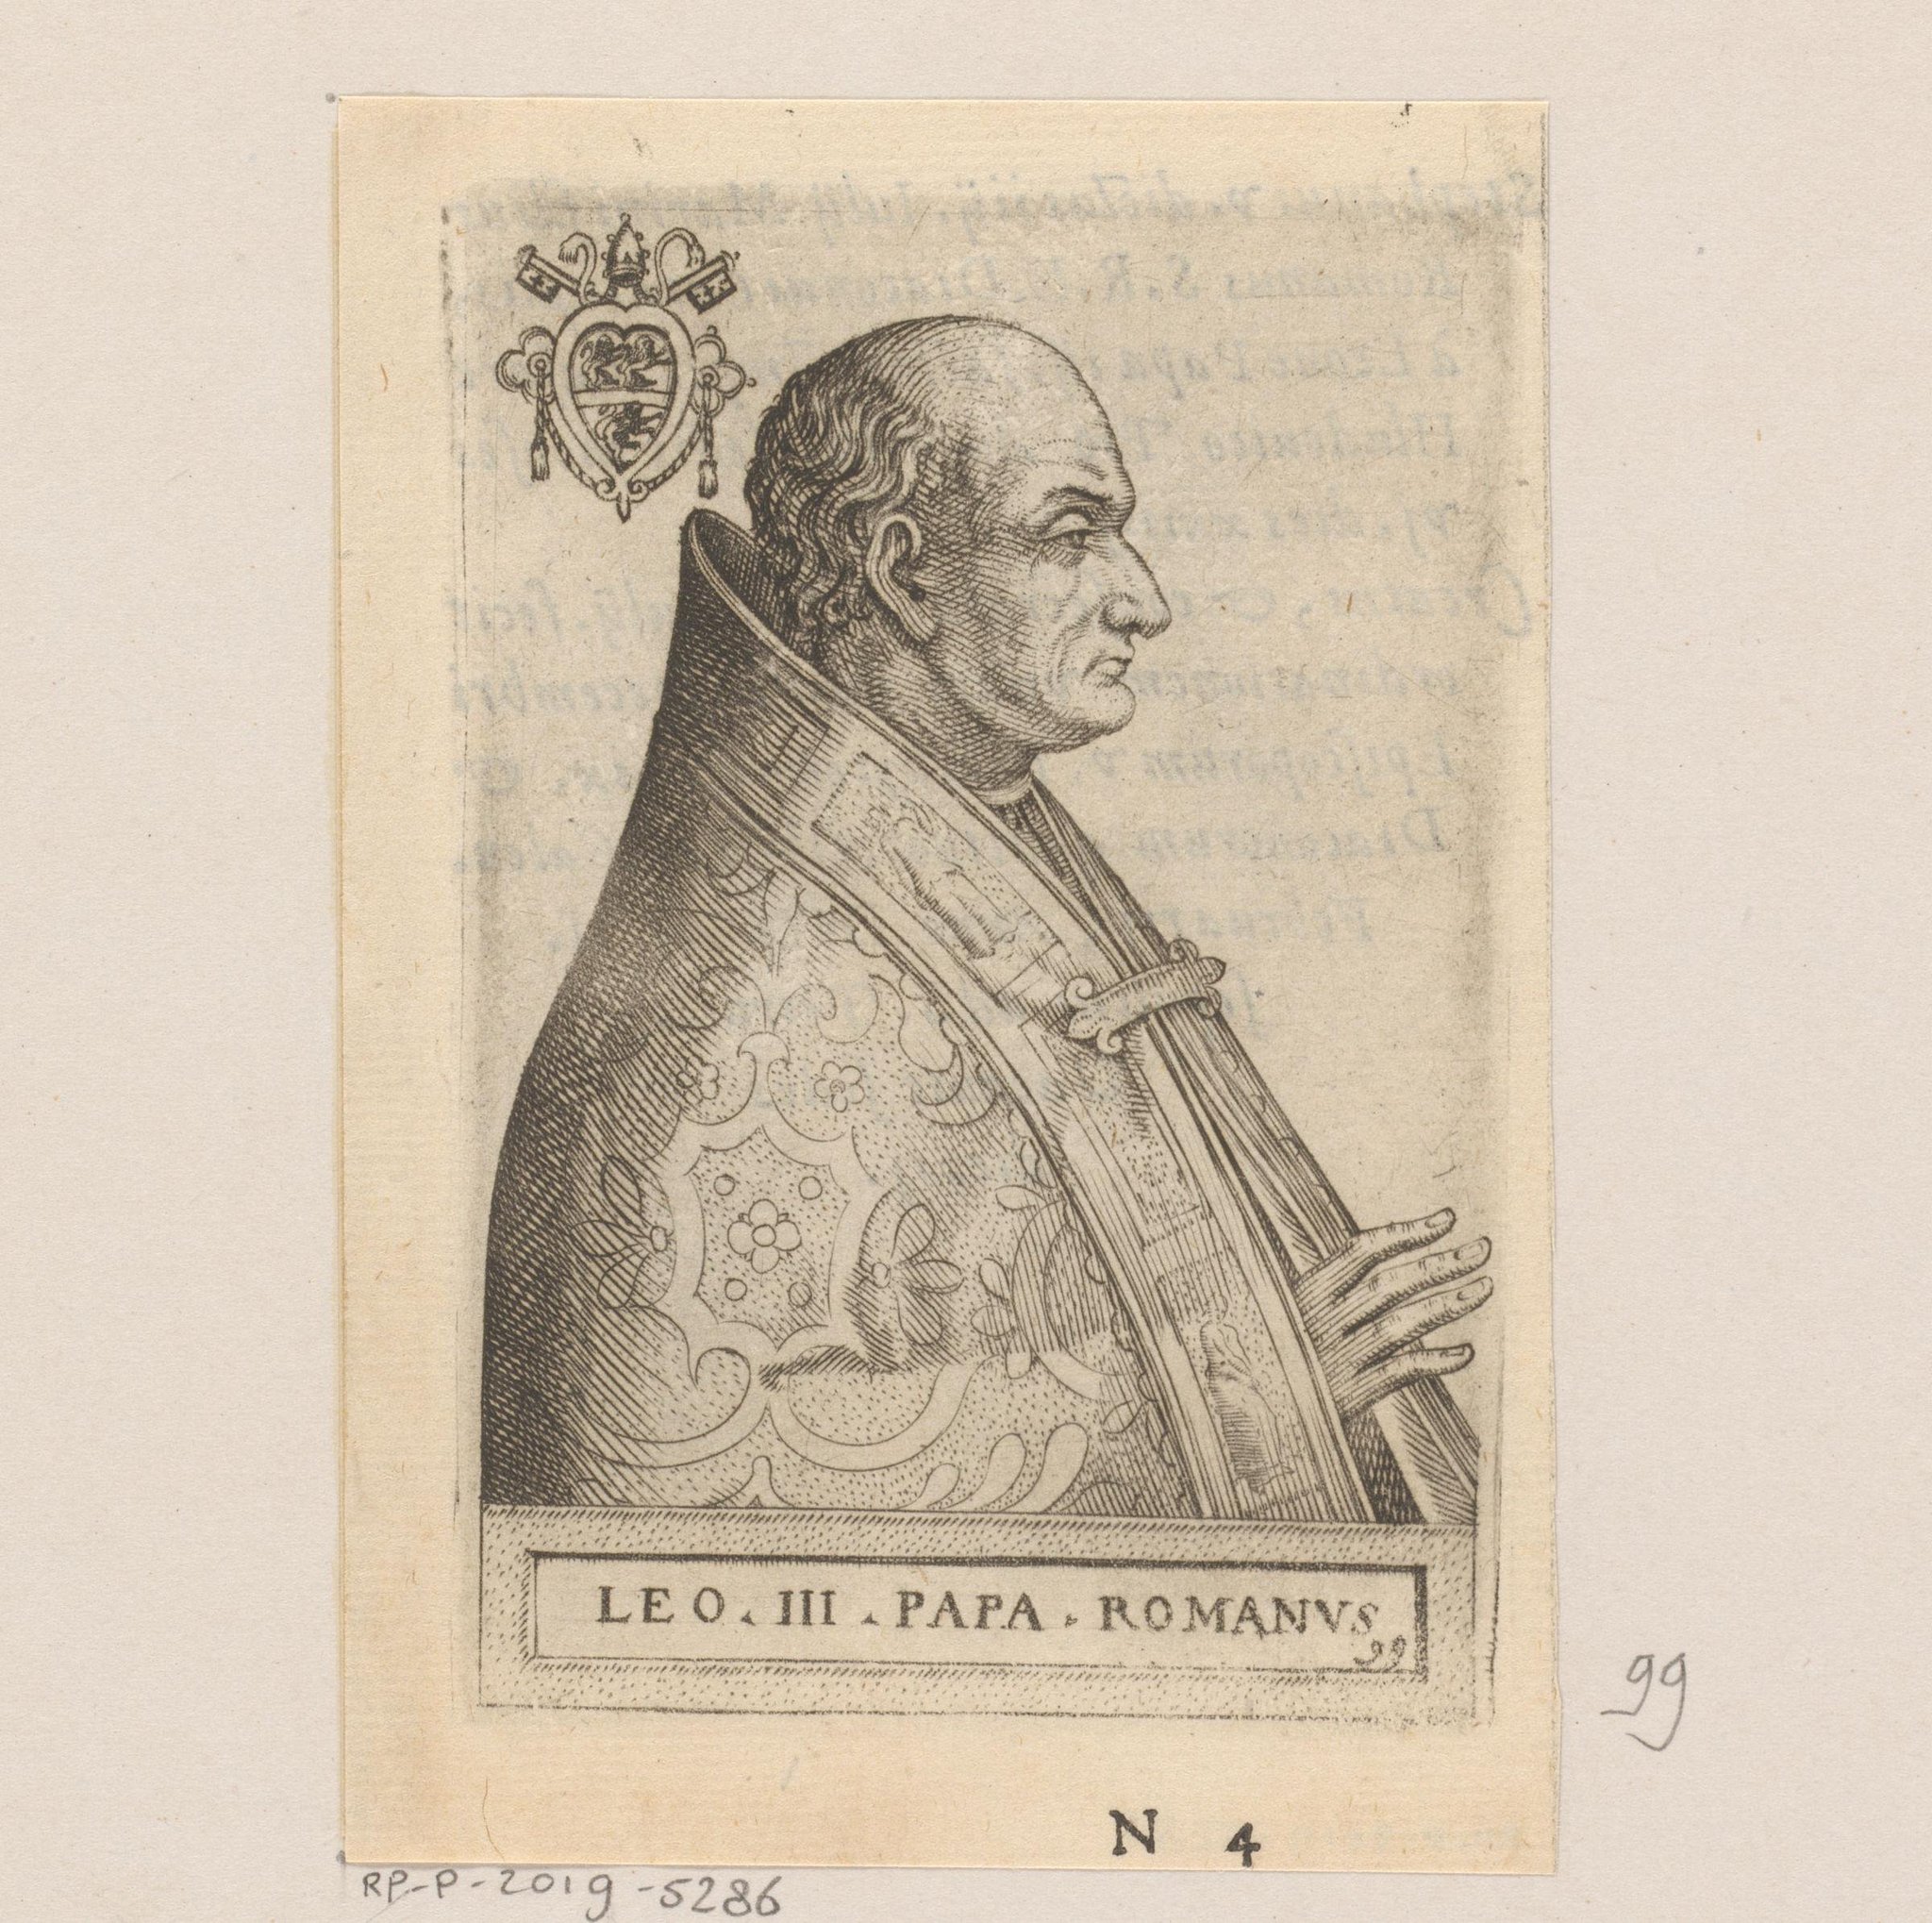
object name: print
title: Portret van paus Leo III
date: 1595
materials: paper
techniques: engraving, letterpress printing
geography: rome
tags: historical persons, pope, armorial bearing, heraldry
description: Prent uit: Cavalieri, Giovanni Battista de'. Effigies pontificum romanorum cum eorum vitis (...). Rome: Bartolomeo Bonfadino, 1595. Prent voor het eerst verschenen in: Cavalieri, Giovanni Battista de'. Pontificum romanorum effigies (...). Rome: Domenico Basa en Francesco Zanetti, 1580. Prent ook gebruikt in latere publicaties.